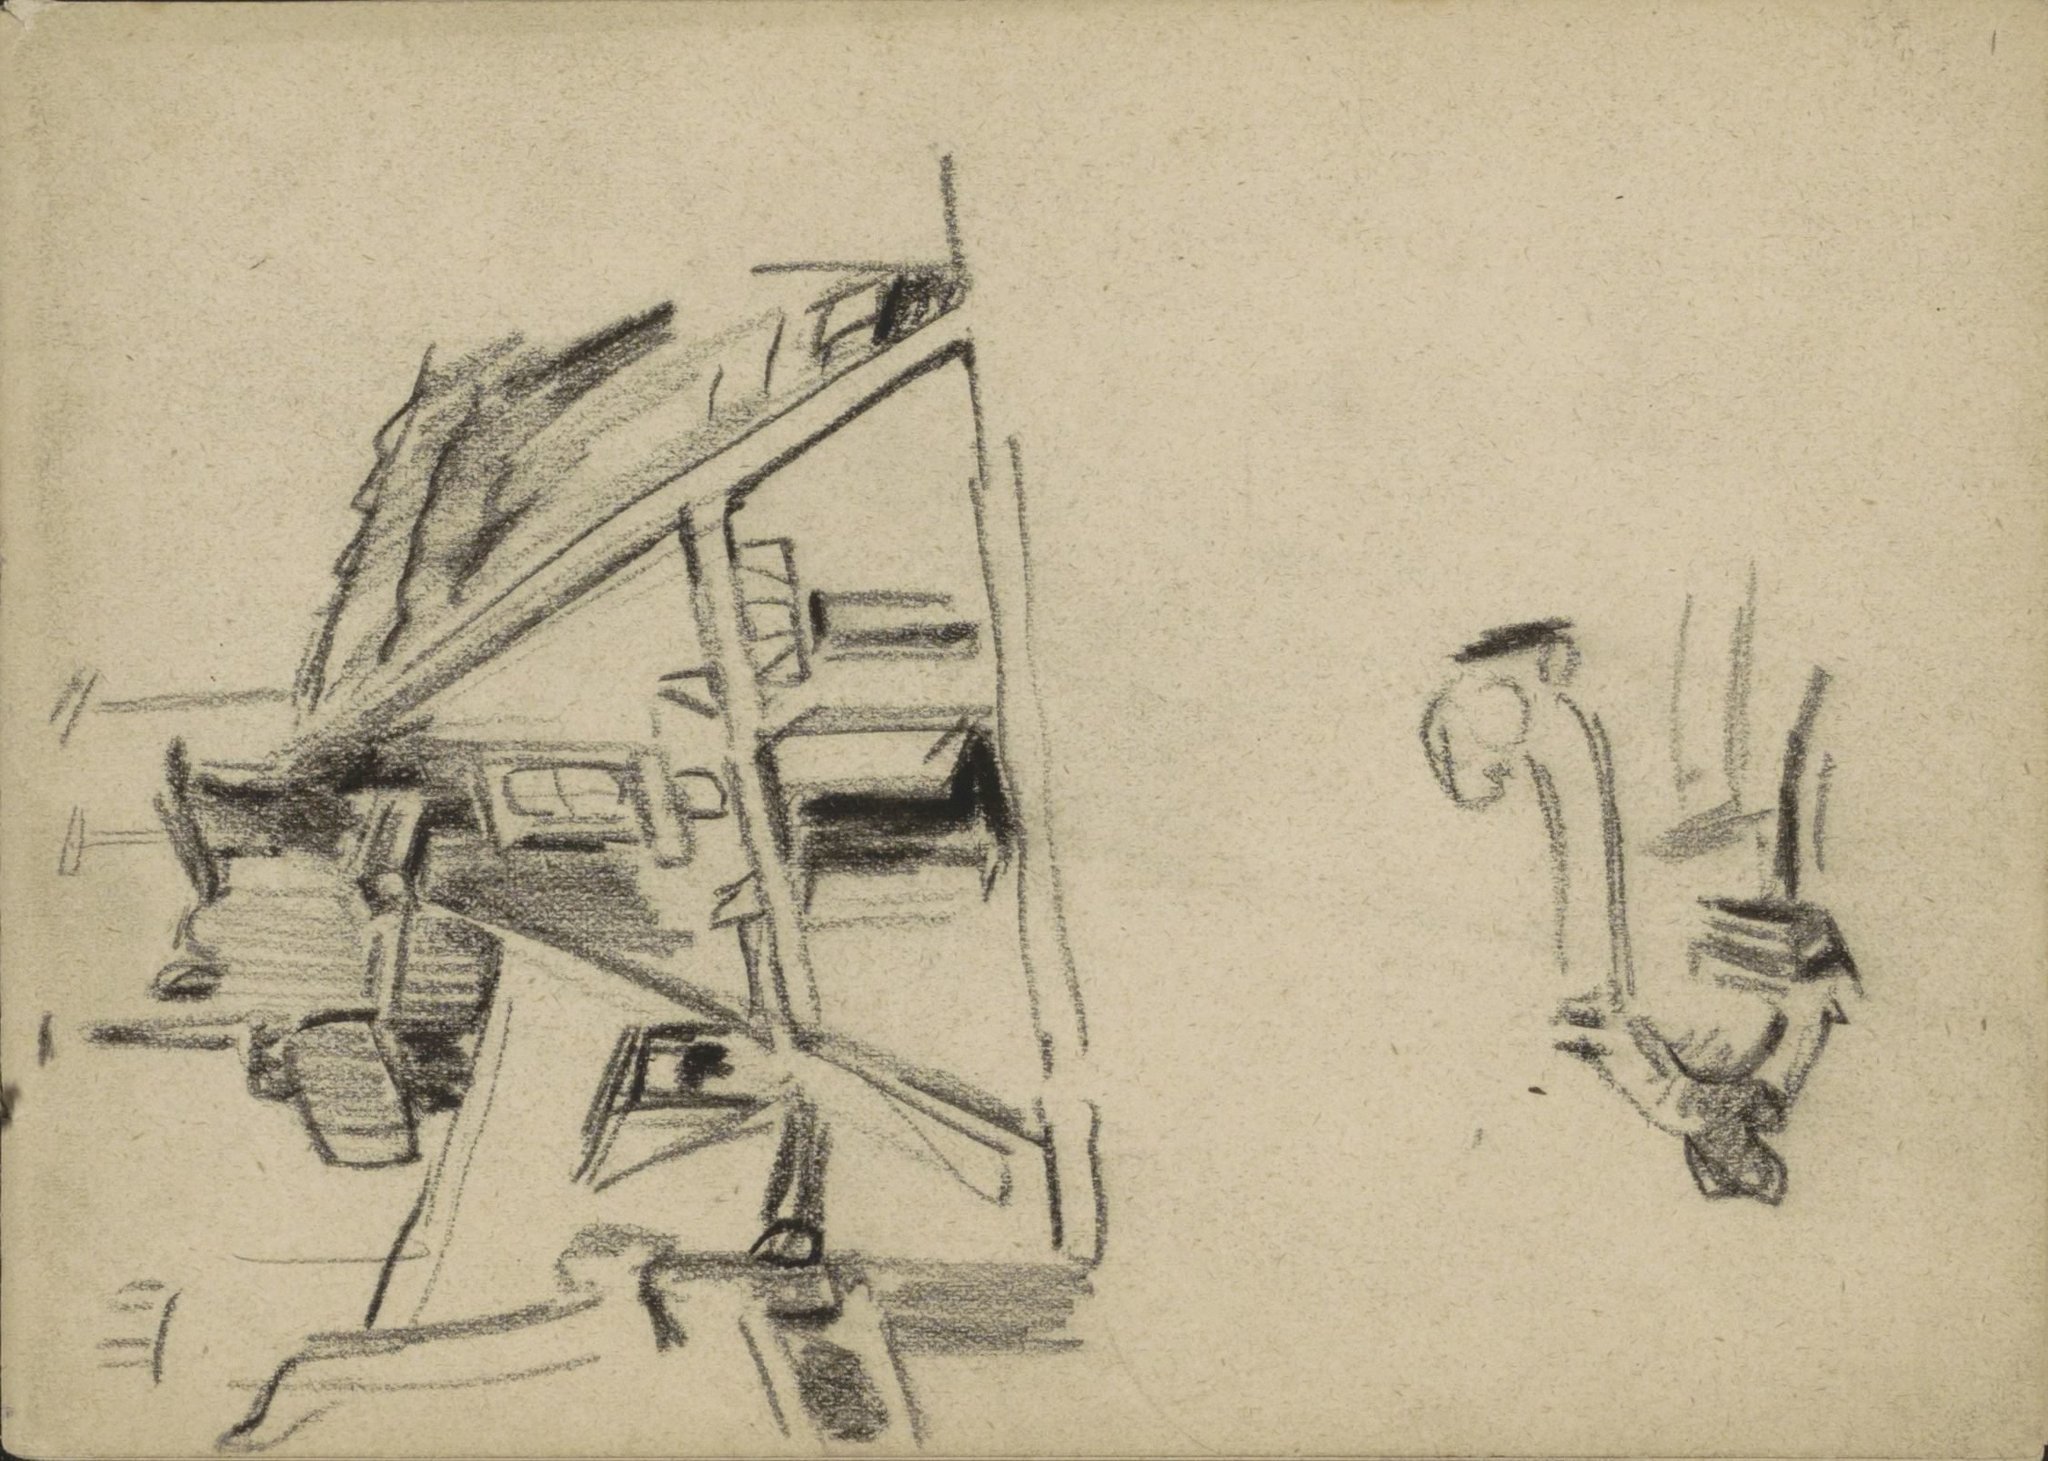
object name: sketchbook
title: Schetsboek met 16 bladen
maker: willem witsen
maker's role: draughtsman, painter, print maker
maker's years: 1860-1923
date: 1870-1923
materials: chalk, paper, pencil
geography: amsterdam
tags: city-view, and landscape with man-made constructions, bridge, amsterdam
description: Pagina's 2 t/m 7, 14, 16, 17, 20 en 21 zijn blanco. De doos bevat naast dit schetsboek nog een tweede (deel van een) schetsboek met het nummer RP-T-1964-215A met acht bladen (waarvan pagina's 51 en 58 t/m 63 blanco), een map van bruin karton en zwart linnen met onderdelen van verschillende, fragmentarisch bewaarde schetsboeken en losse bladen. De gehele inhoud is doorgenummerd.